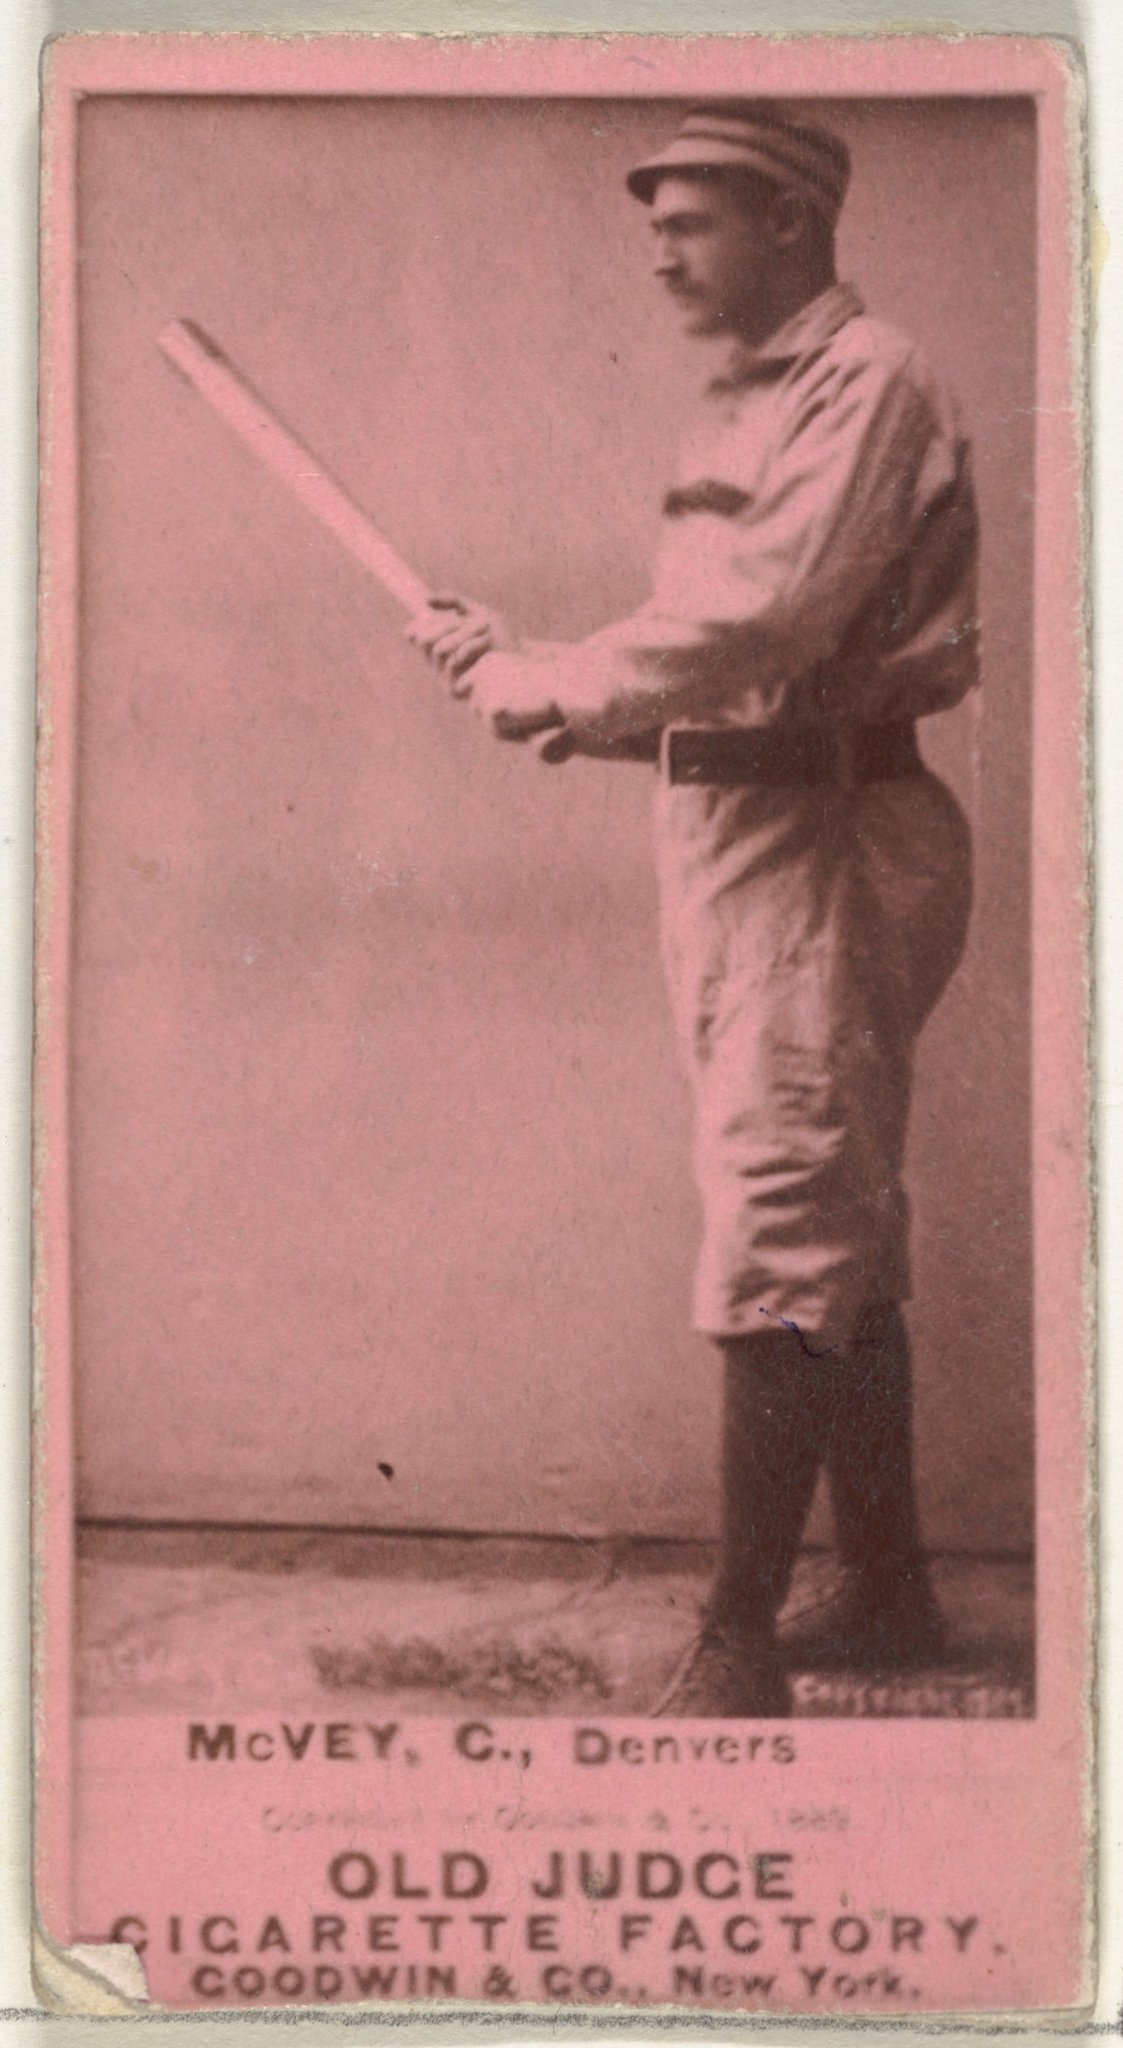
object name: baseball card, photograph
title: George W. McVey, Catcher, Denver, from the Old Judge series (N172) for Old Judge Cigarettes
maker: goodwin & company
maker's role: publisher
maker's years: 1850-1950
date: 1888-1889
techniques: albumen silver print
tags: men,portraits,baseball,athletes